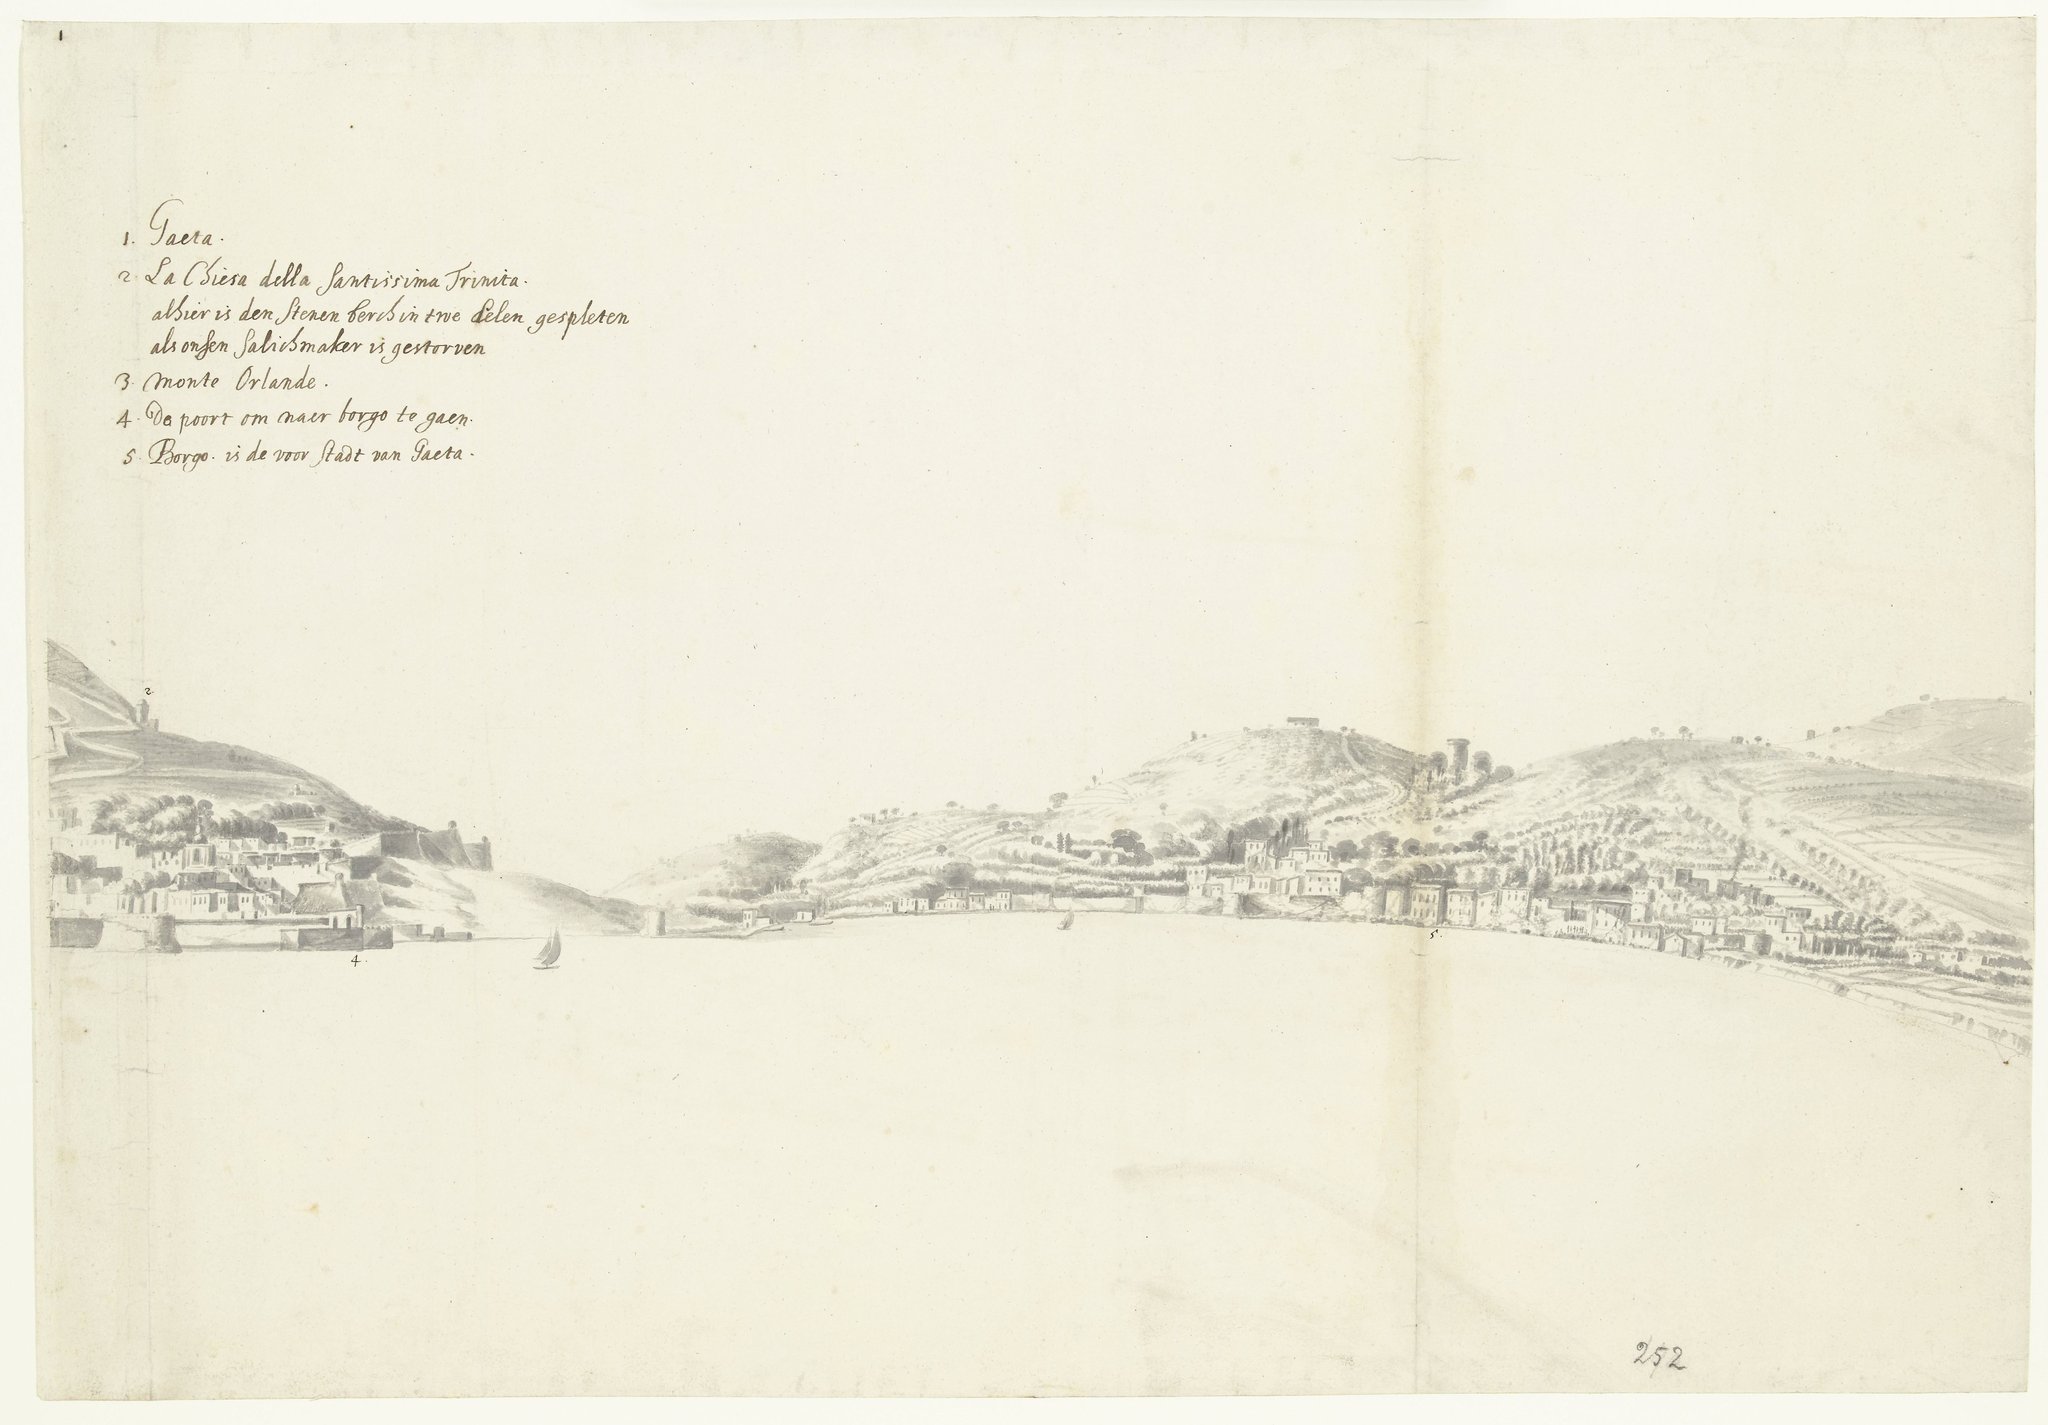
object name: drawing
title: Gezicht op de Italiaanse stad Gaeta (rechterblad)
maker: Anonymous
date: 1600-1699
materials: paper, pencil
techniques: brush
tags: harbour, prospect of city, town panorama, silhouette of city, italy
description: Rechterblad van voorstelling op twee bladen met een gezicht op Gaeta (linkerblad heeft objectnummer RP-T-00-409).